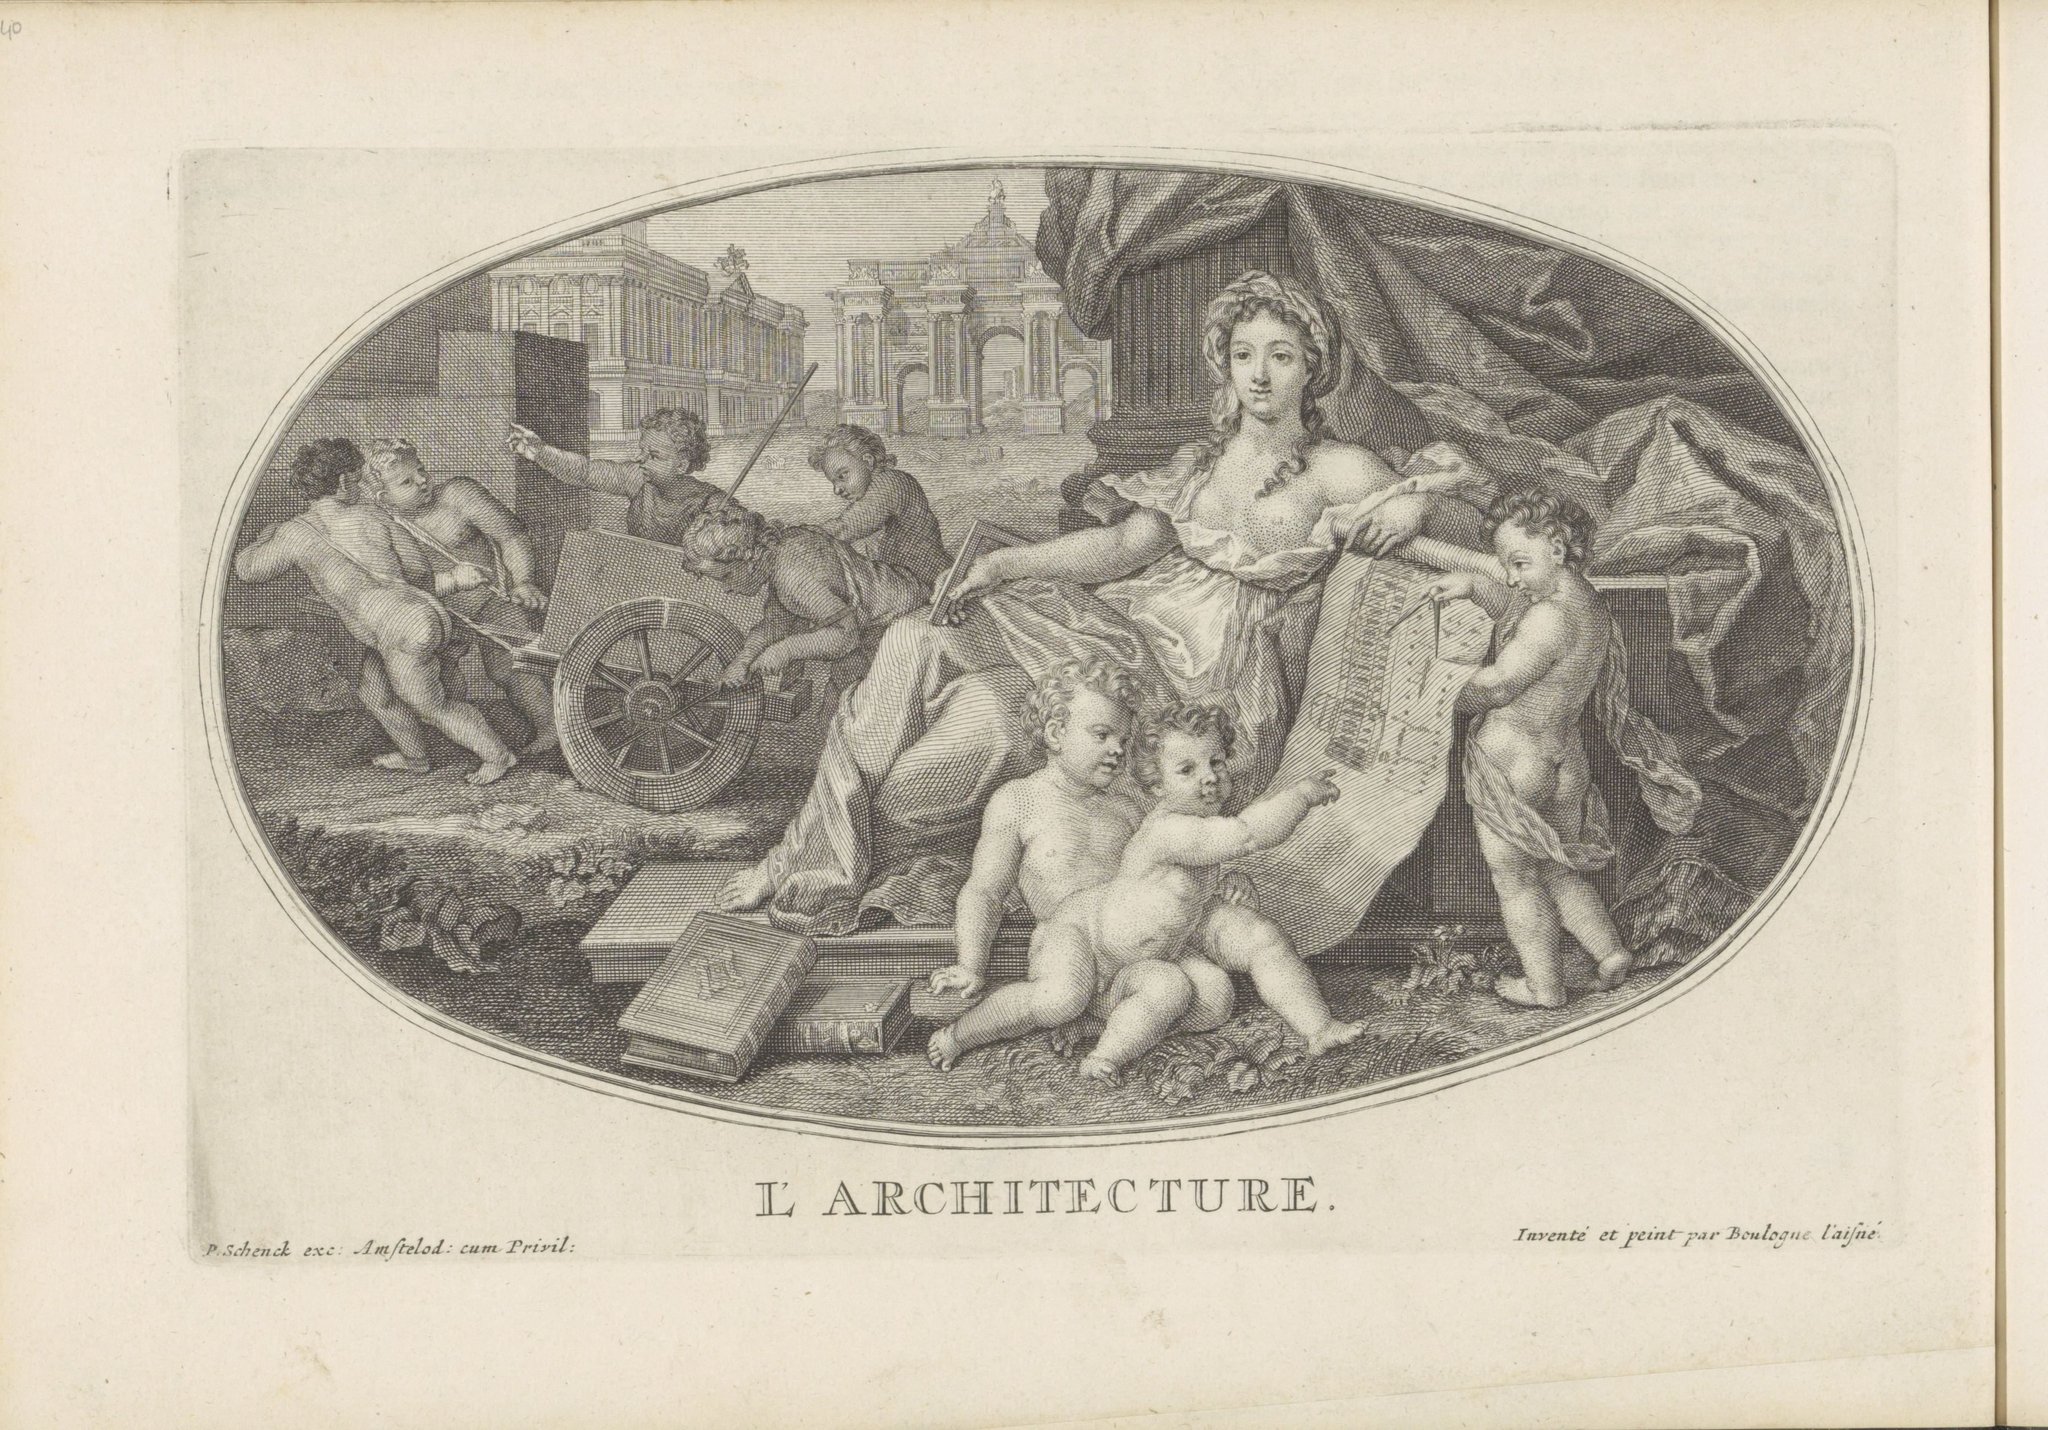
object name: print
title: Architectuur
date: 1693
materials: paper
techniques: engraving, etching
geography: amsterdam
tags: 'architectura', symbolic representations, allegories and emblems ~ architecture; 'architettura' (ripa), (decorated) ceiling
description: Plafondstuk met de personificatie van Architectuur. In haar hand houdt zij een bouwtekening met de opstand en plattegrond van een gebouw. Links kinderen die een bouwsteen met een kar verplaatsen. Prent maakt deel uit van een album.